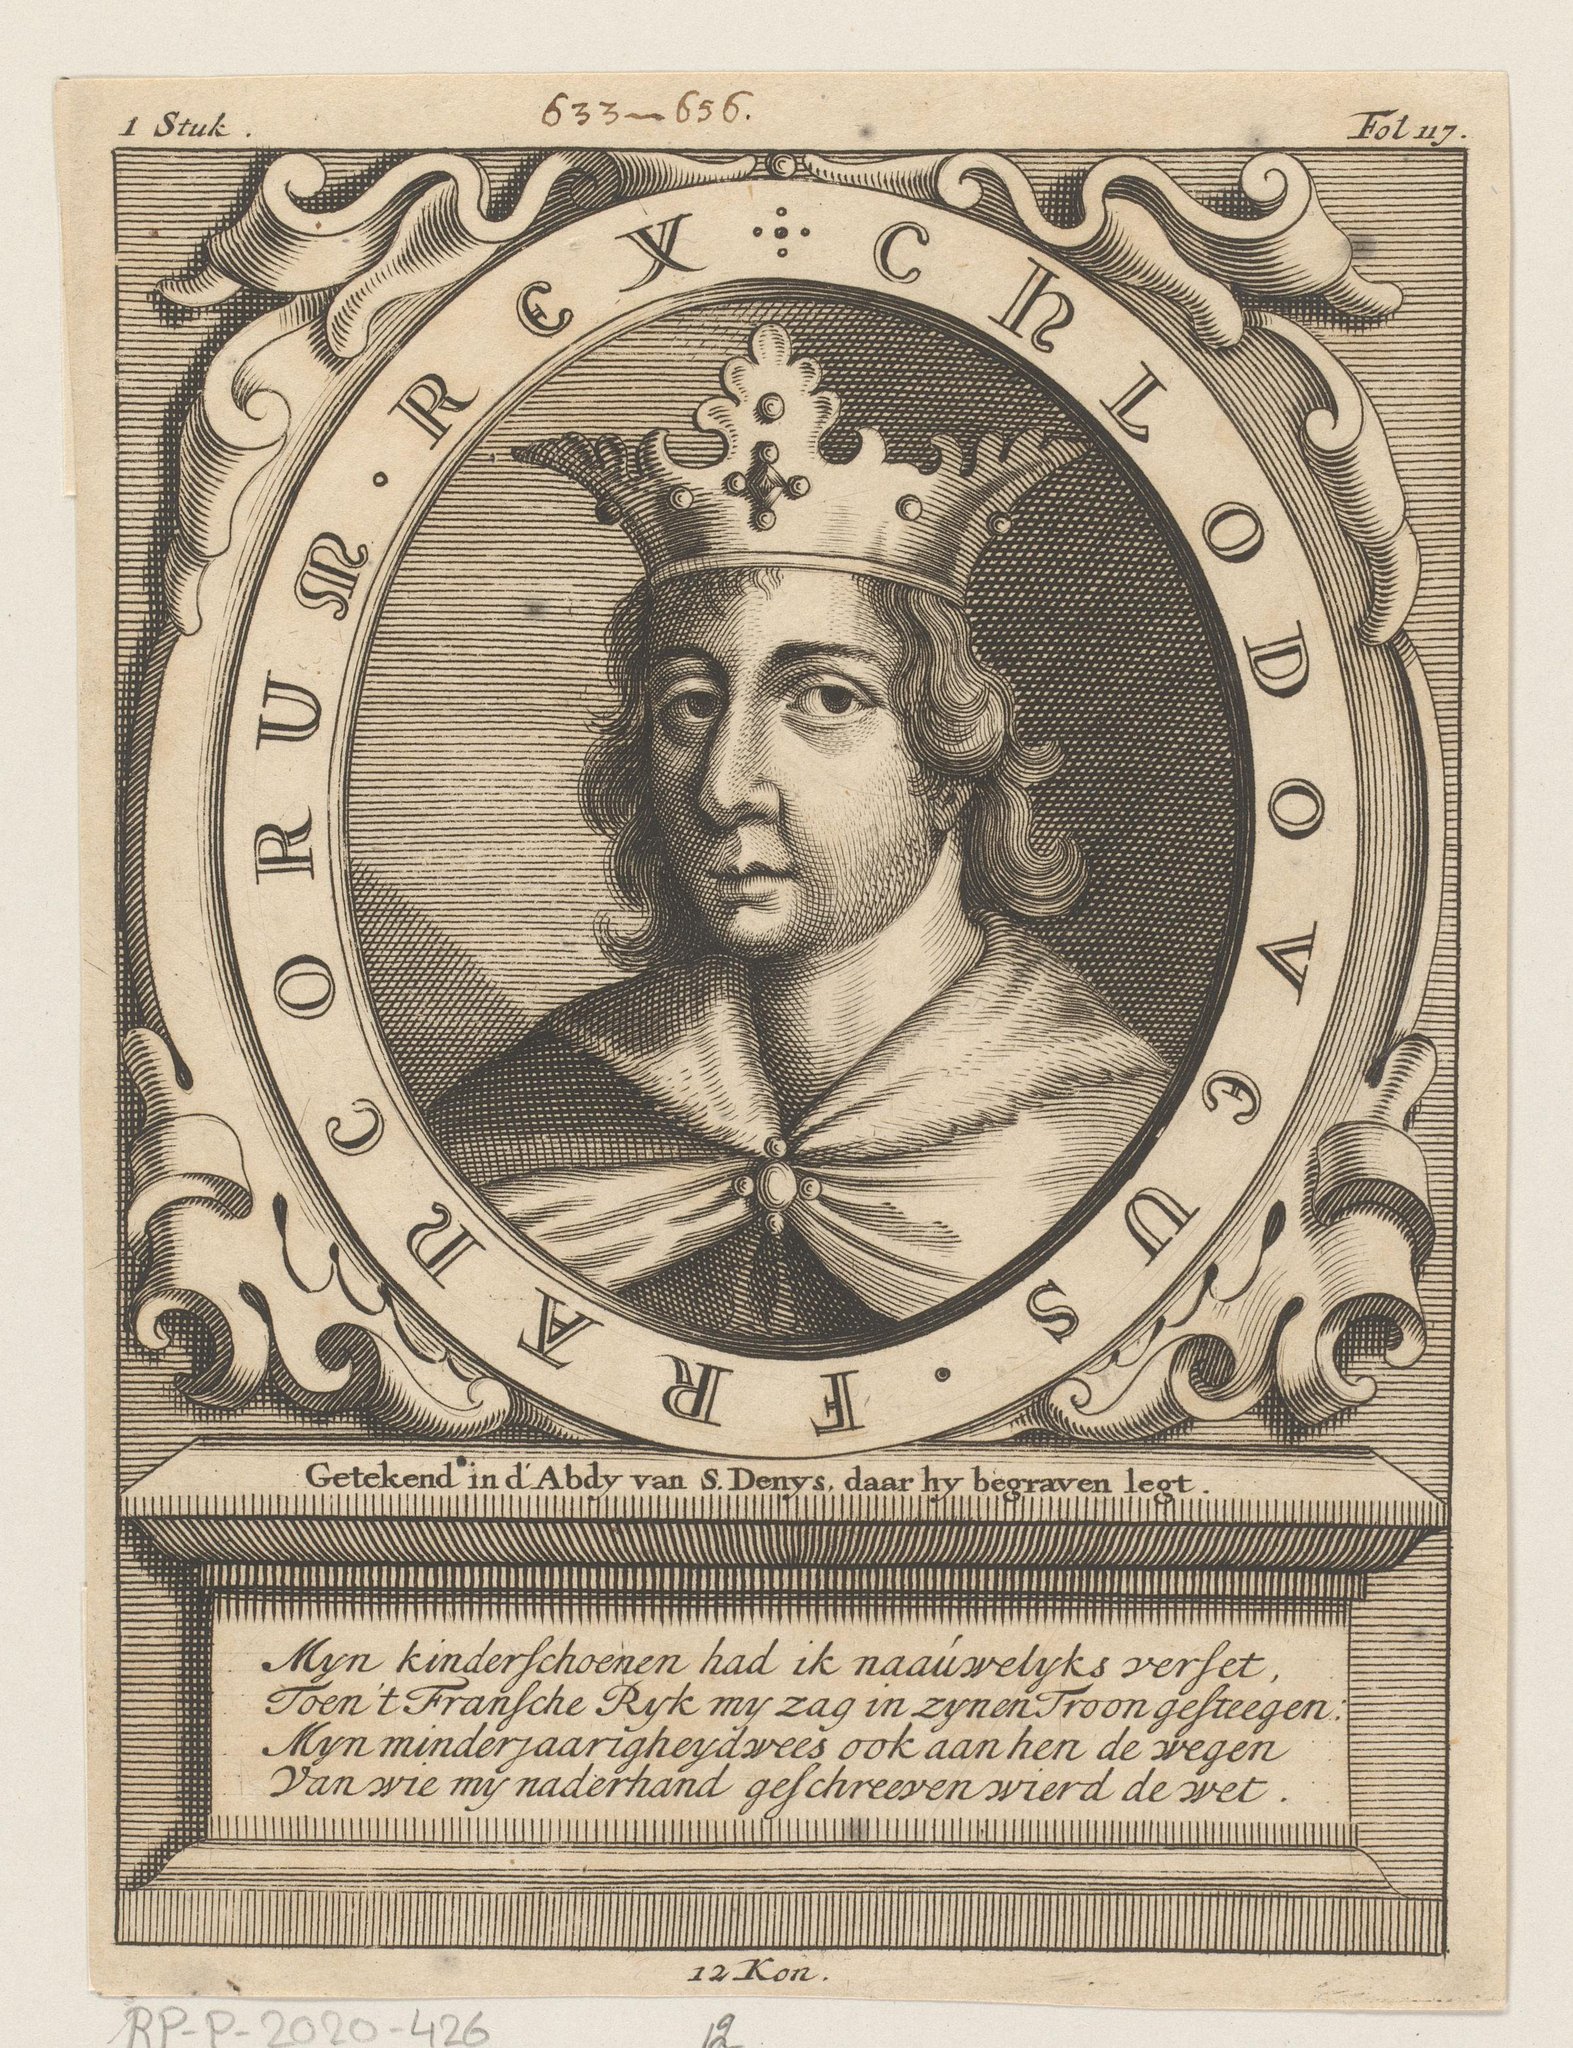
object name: print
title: Portret van Clovis II, koning van Neustrië en Bourgondië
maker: Anonymous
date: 1685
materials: paper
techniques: engraving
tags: historical persons, ruler, sovereign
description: Prent ook gebruikt in: Eudes de Mézeray, François. Chronyk van Vrankryk. 6 dln. Amsterdam: Jan Bouman en Timotheum ten Hoorn, 1685, dl. 1.